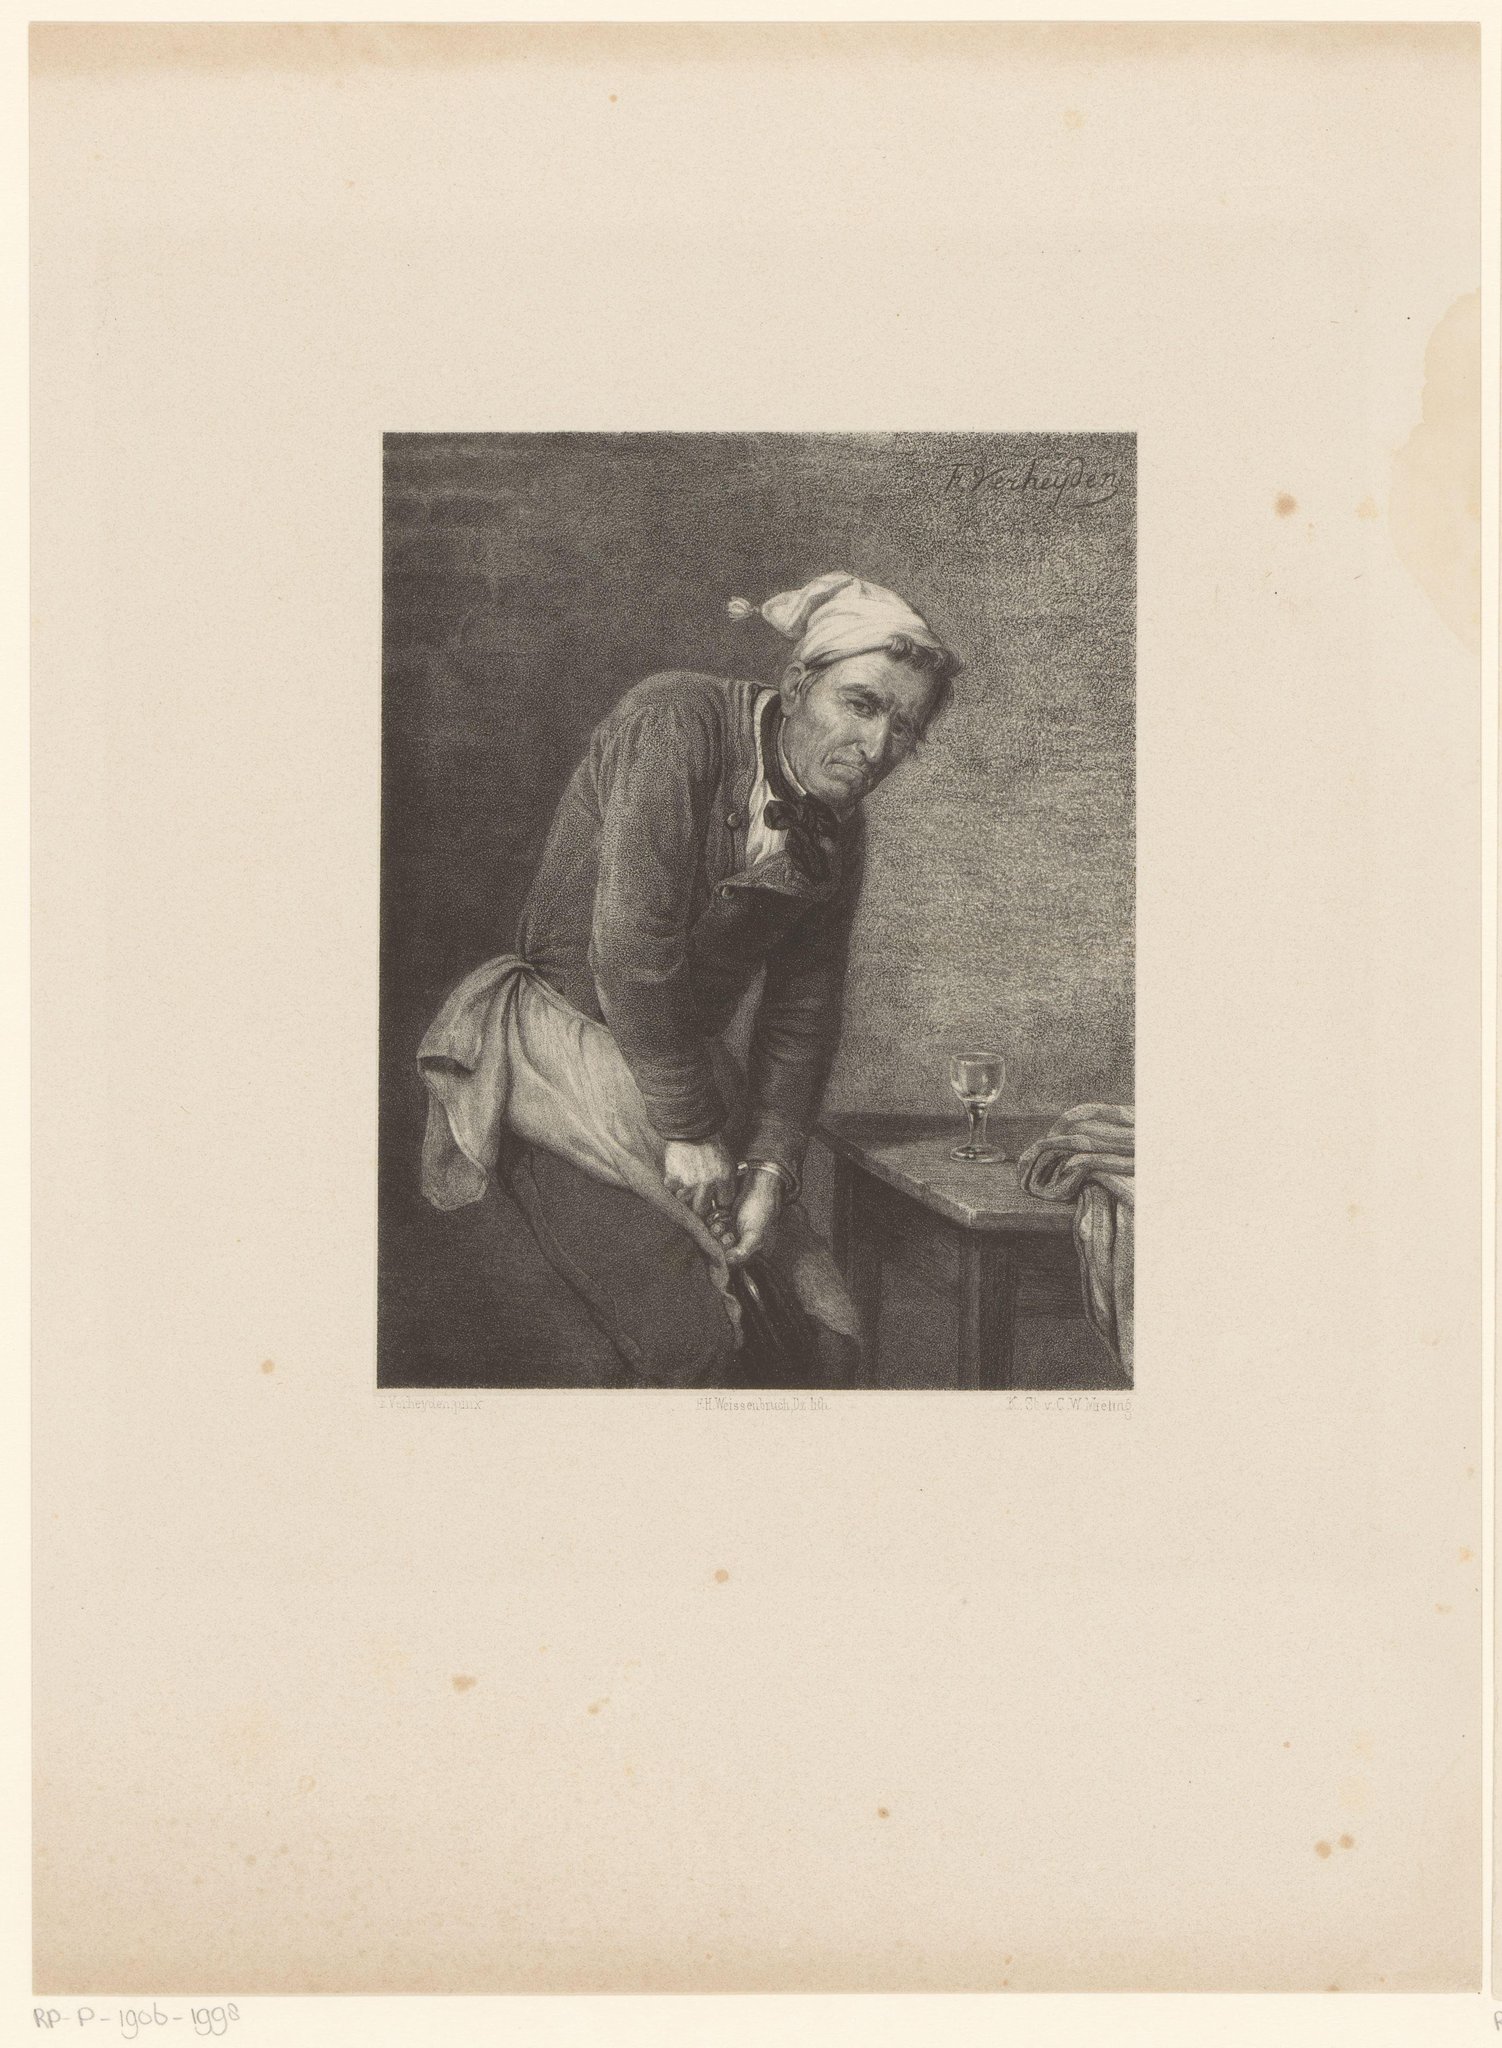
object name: print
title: Man trekt fles open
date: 1847-1865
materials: paper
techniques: lithograph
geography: the hague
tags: kitchen-utensils, bottle of wine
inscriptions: collector's mark: Lugt 2228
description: Een man met muts klemt een fles tussen zijn benen en staat op het punt hem met een kurkentrekker te openen. Rechts op tafel staat een leeg wijnglas.